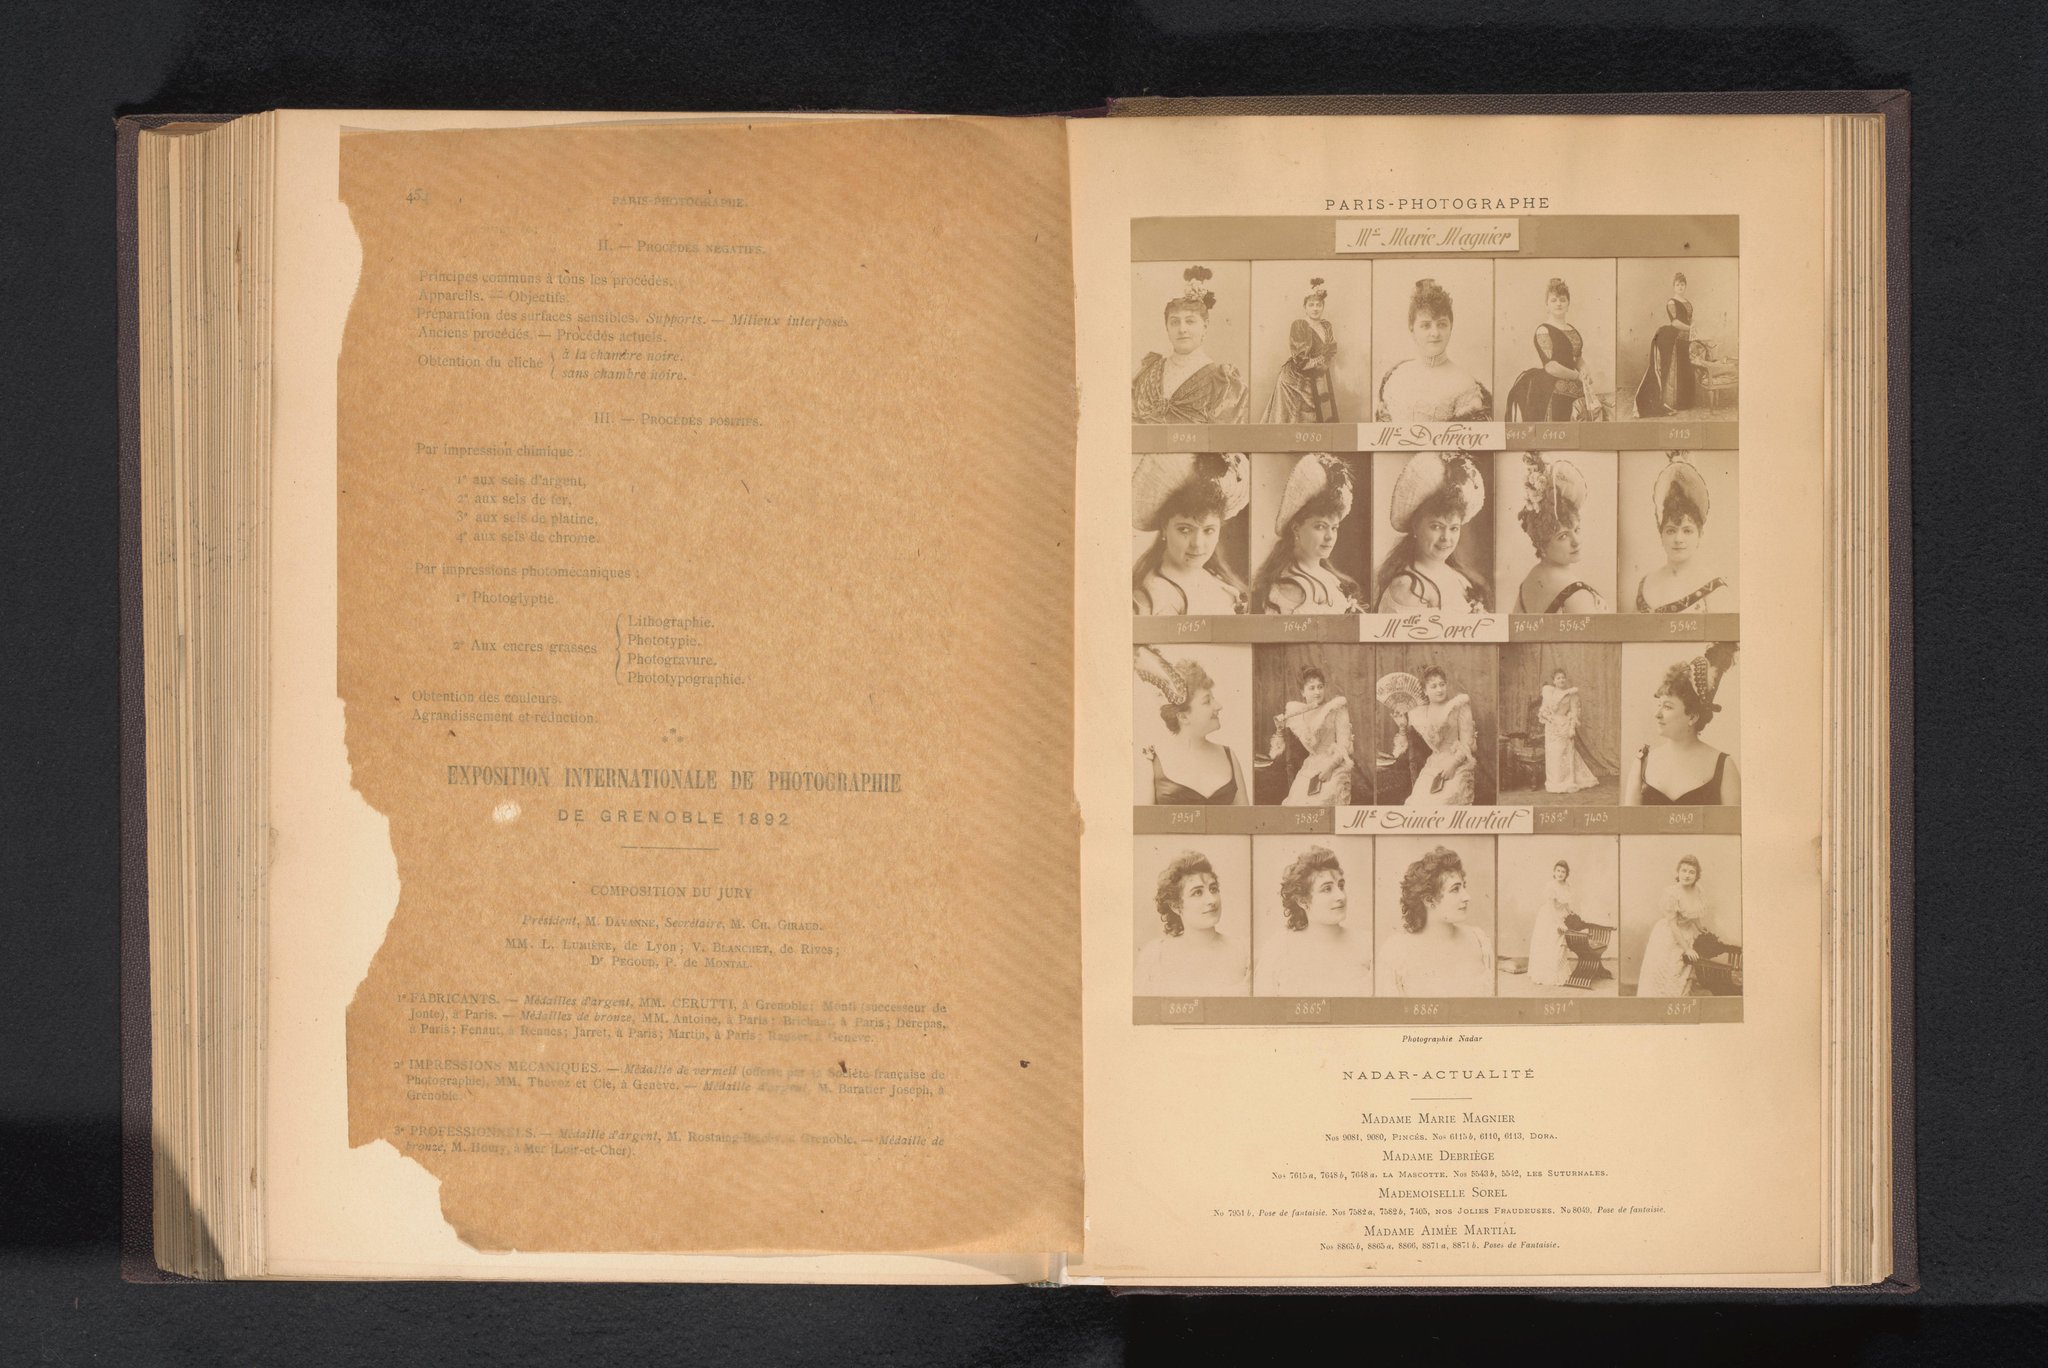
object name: photograph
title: Twintig portretten van Marie Magnier, Albany Debriege, Cécile Sorel en Aimée Martial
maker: félix nadar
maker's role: ballonvaarder, fotograaf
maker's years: 1820-1910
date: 1882-1892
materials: photographic support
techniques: albumen print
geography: paris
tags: stage costume, portrait of actor, actress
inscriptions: inscription: ‘Madame Marie Magnier (...) Madame Debriège (...) Mademoiselle Sorel (...) Madame Aimée Martial (...)’, number: ‘9081 (...) 8871B’